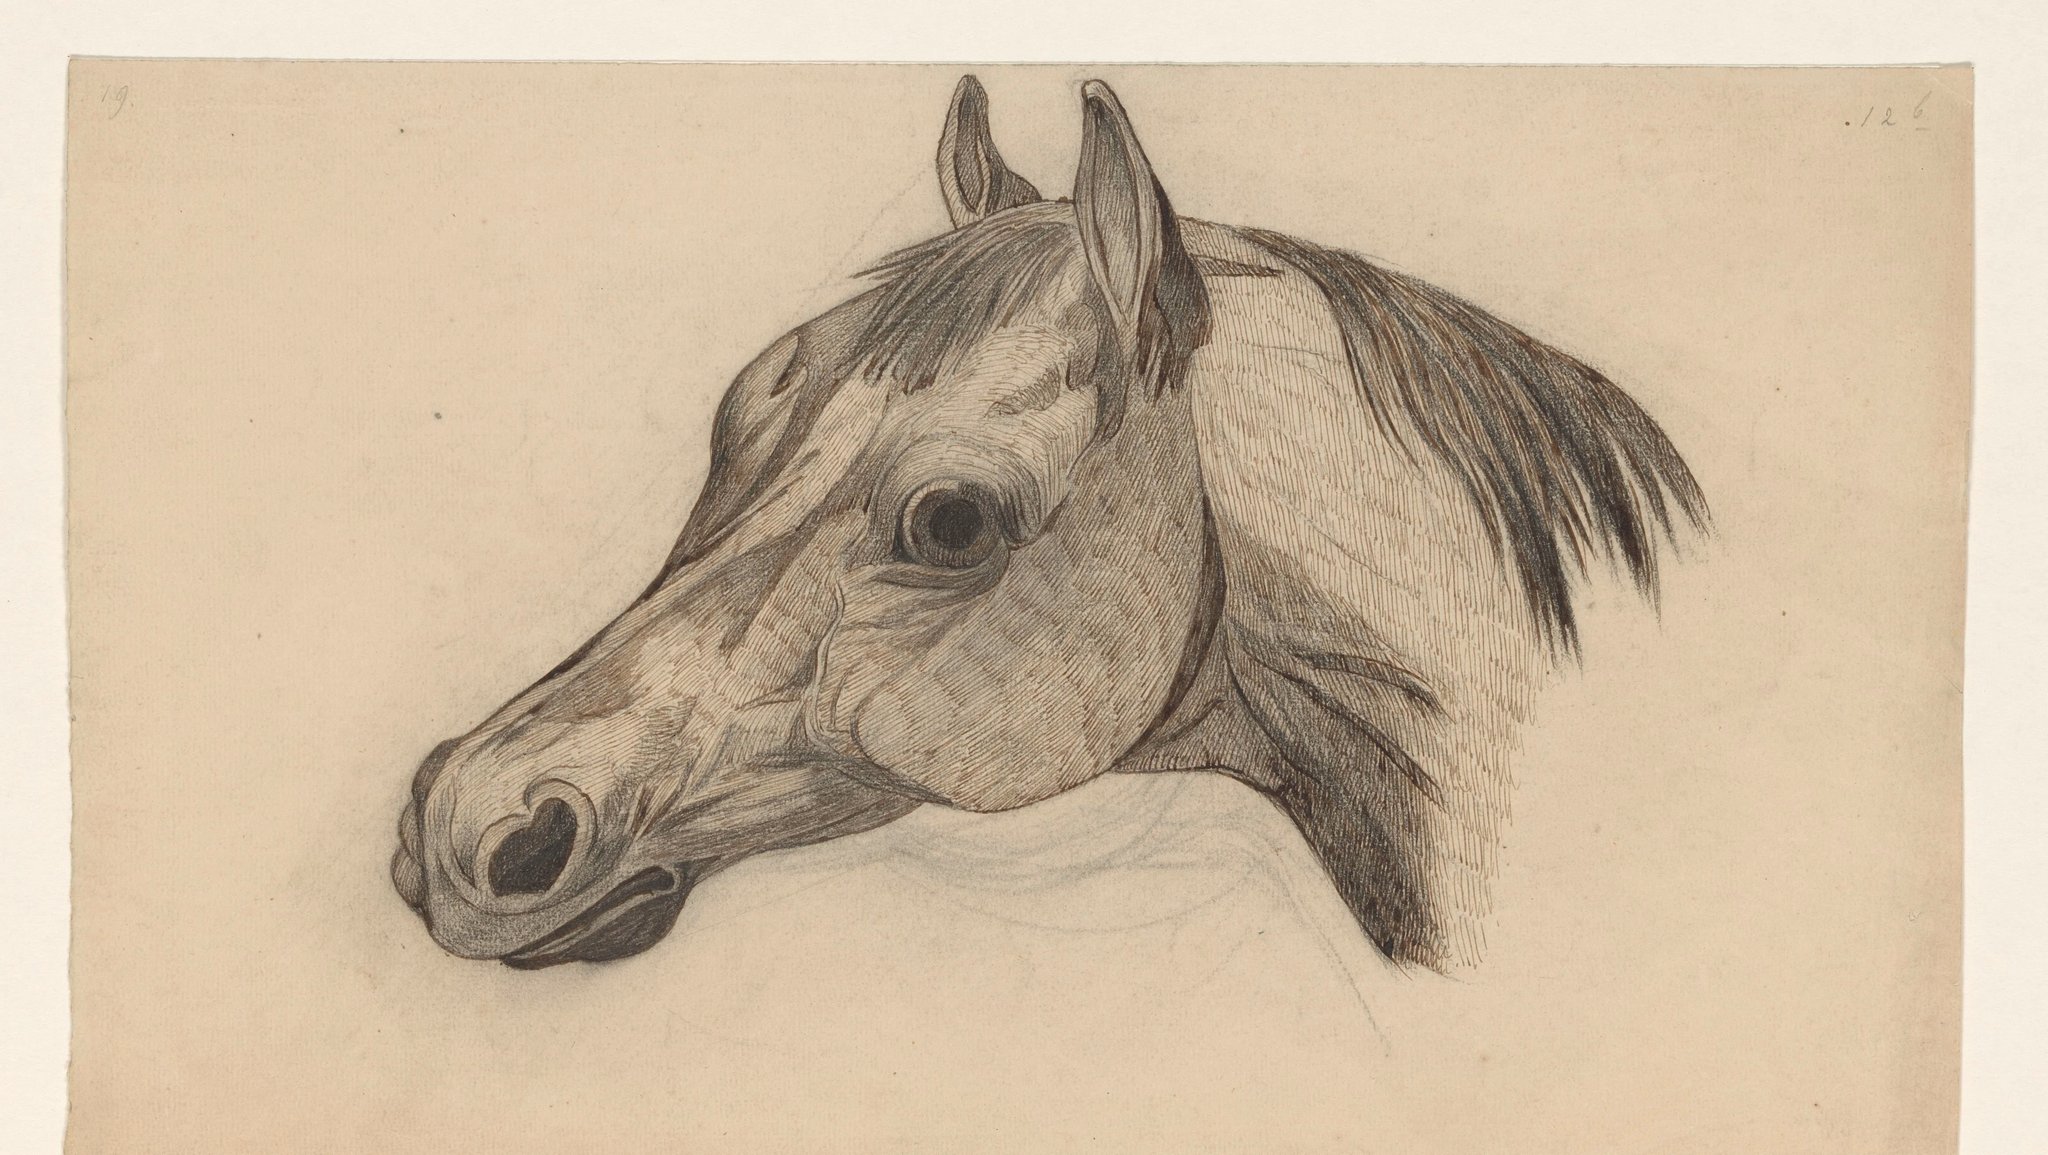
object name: drawing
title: Kop van een paard, naar links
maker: dirk arnoldus tavenraat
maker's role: draughtsman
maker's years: 1845-1930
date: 1855-1930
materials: chalk, ink, paper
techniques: pen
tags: horse